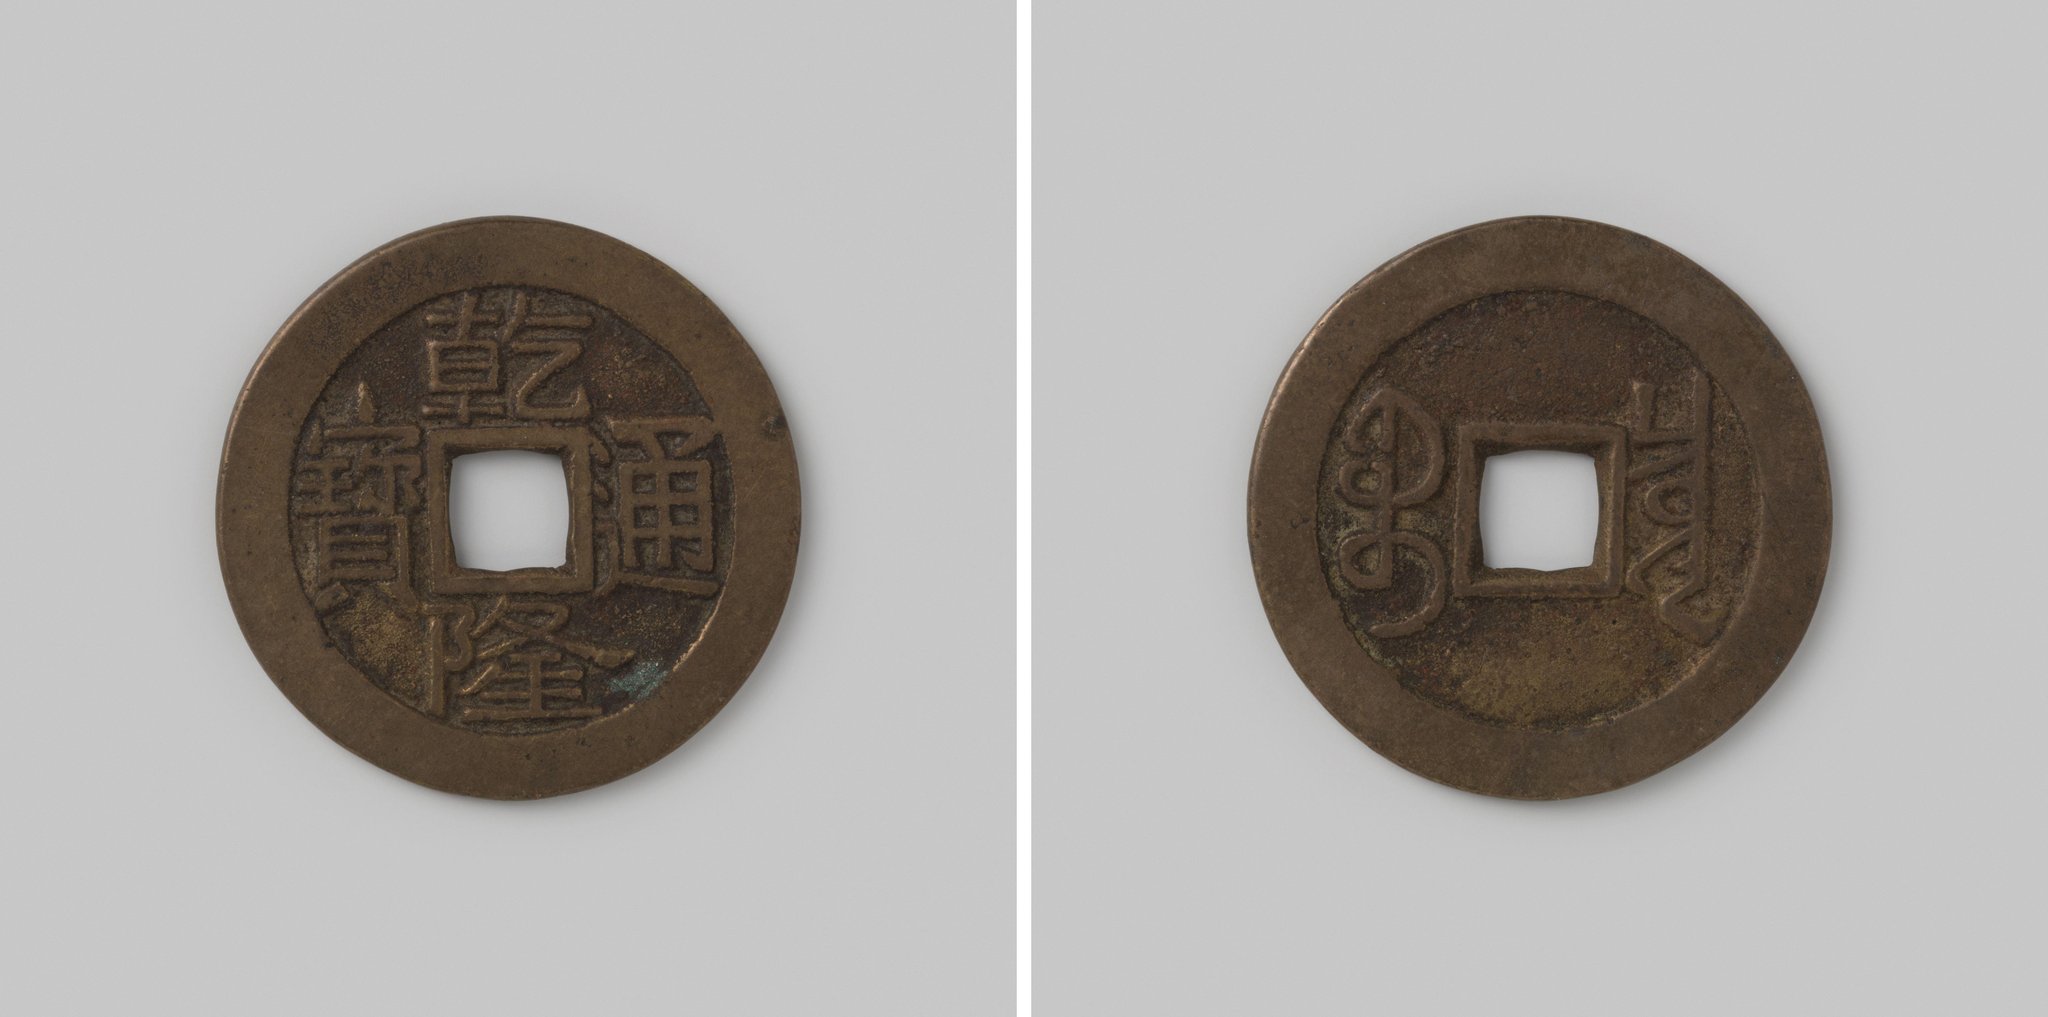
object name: coin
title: Cash van het keizerrijk China van keizer Shi Tsung onder de regeringsnaam Ch ien-Lung,1736-1795, in opdracht van het Departement van Financiën te Bejing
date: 1736-1795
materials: copper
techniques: casting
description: Koperen munt. Voorzijde: binnen brede opstaande rand rondom vierkante uitsparing in het midden vier kruisgewijze geplaatste Chinese tekens, waarvan twee met de betekenis: Ch ien lung. Keerzijde: binnen brede opstaande rand ter weerszijden van vierkante uitsparing in het midden twee Chinese tekens, waarbij het rechter teken met de betekenis in Manchu: Chuan = Financiën.